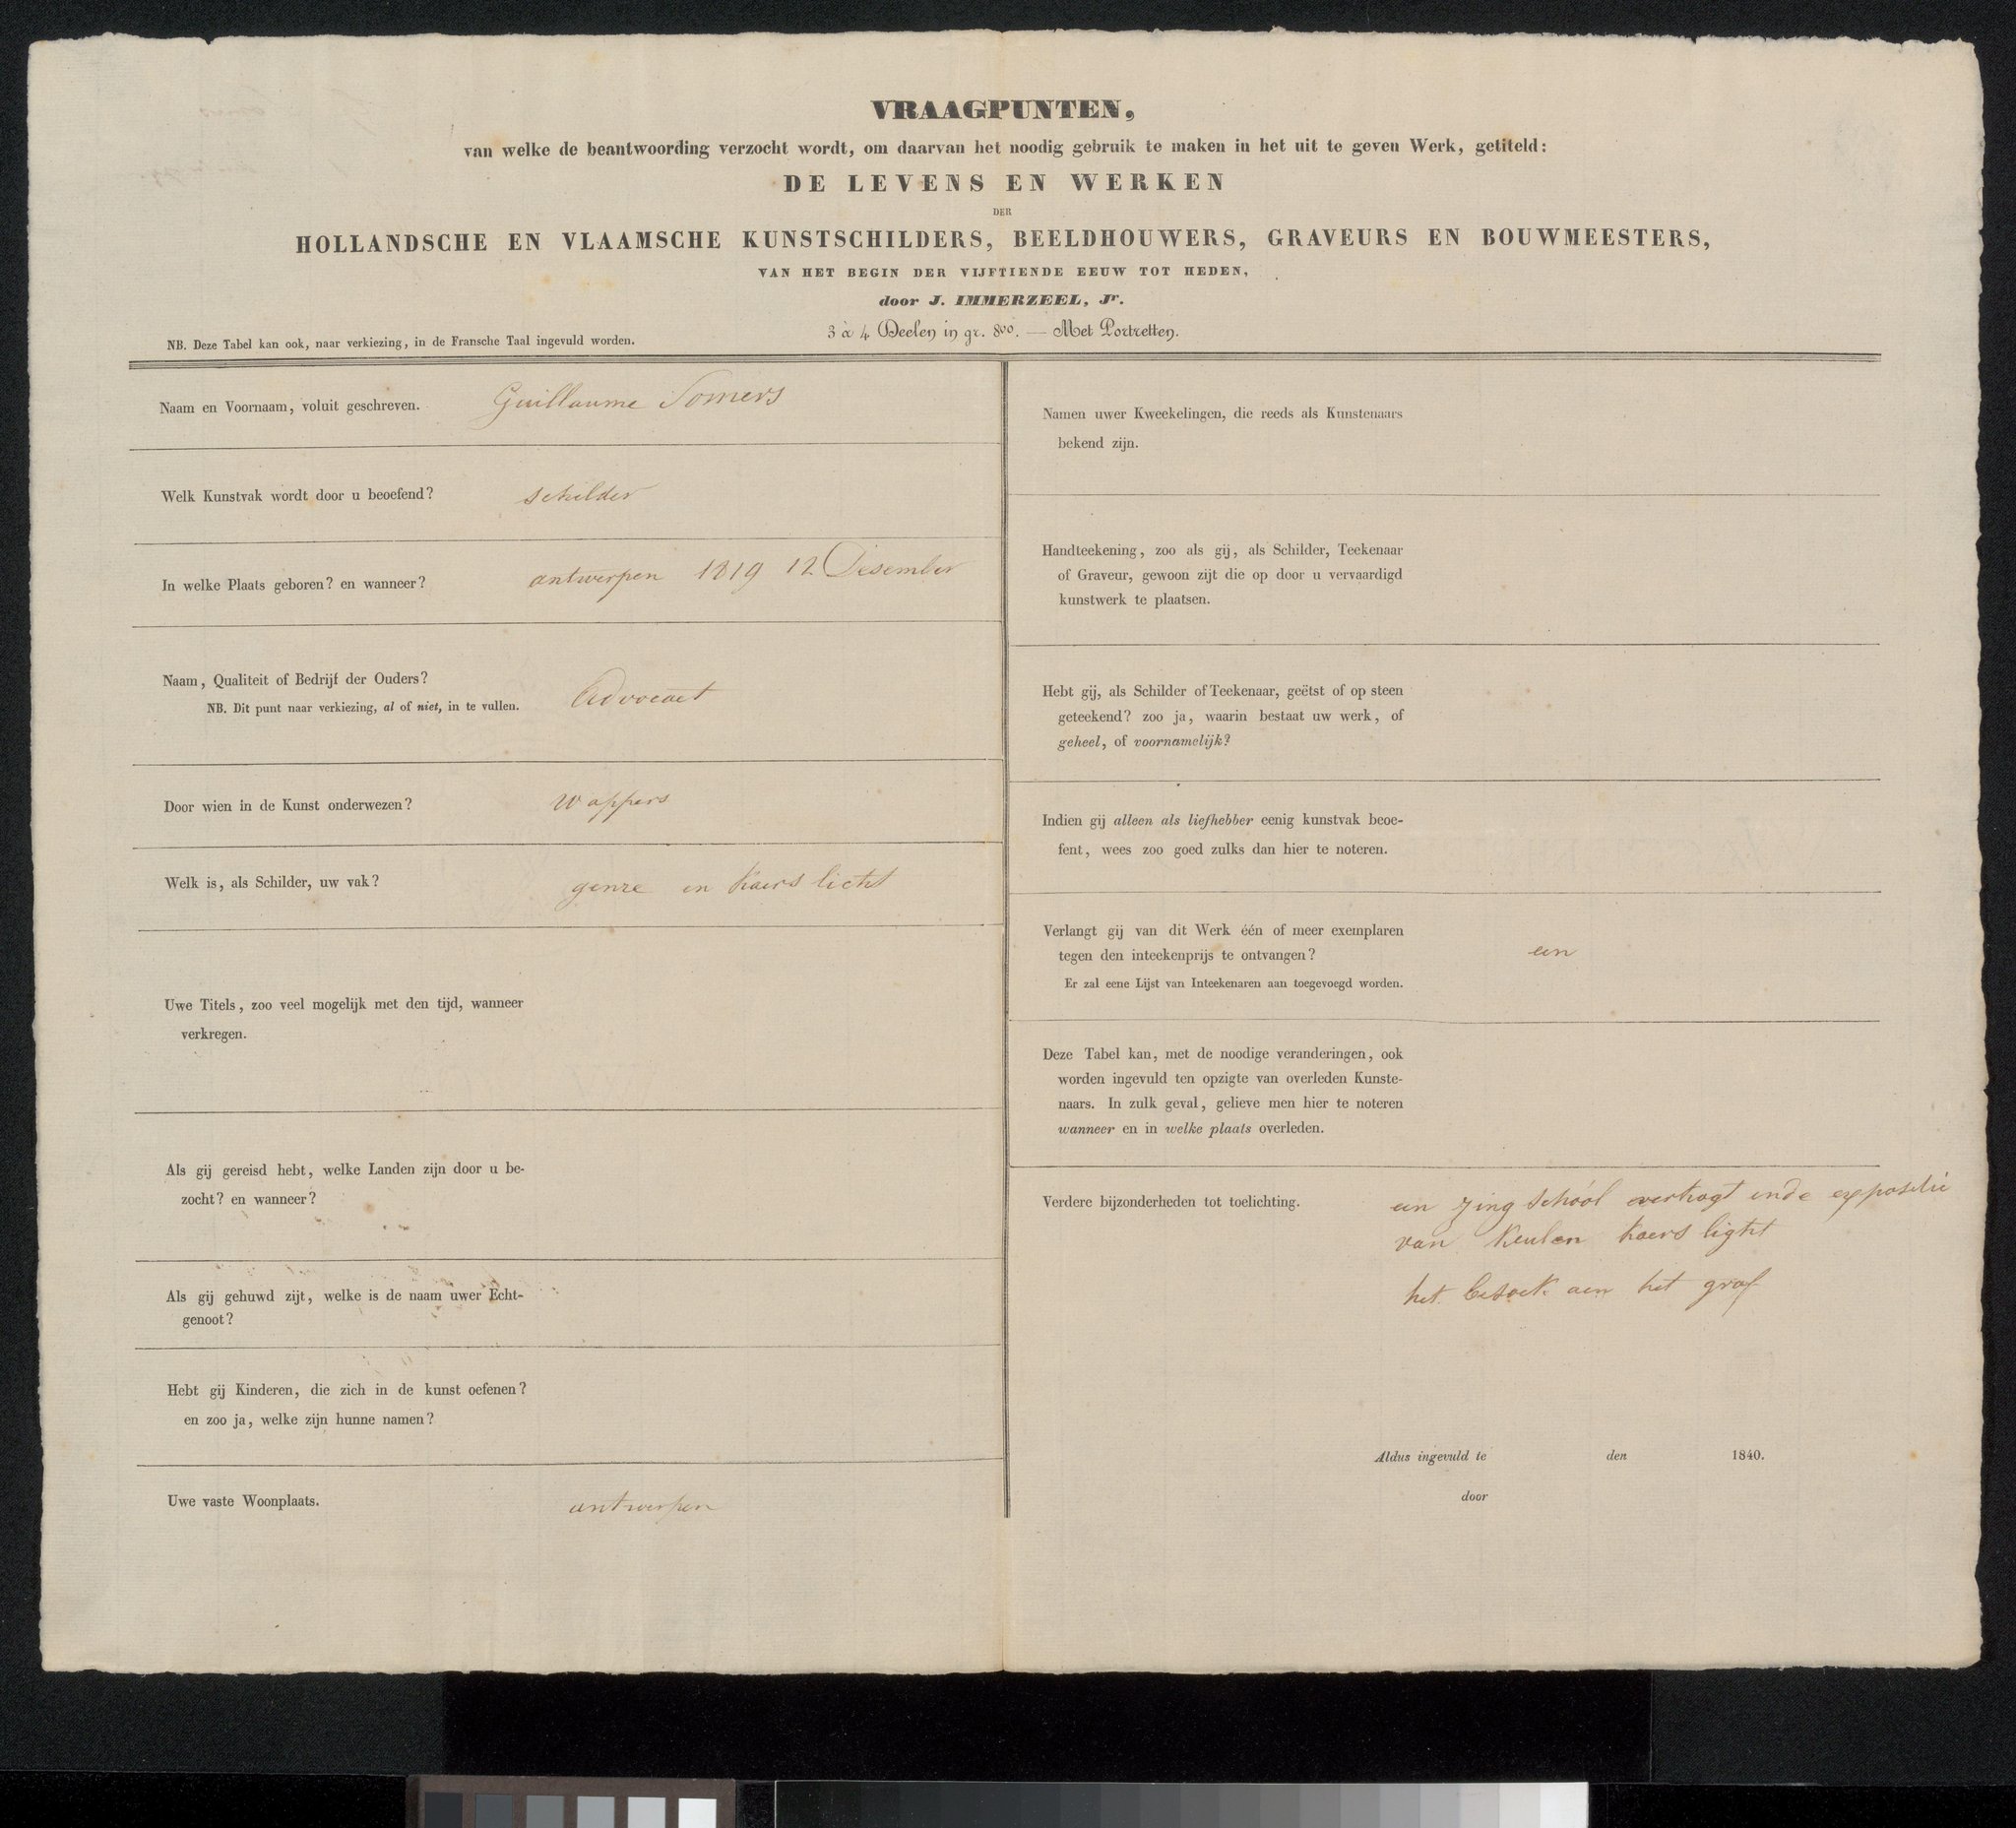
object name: manuscript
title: Enquêteformulier ingevuld door Guillaume Somers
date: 1840-1841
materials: ink, paper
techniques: pen, printing, writing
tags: antwerp, painter, guillaume somers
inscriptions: inscription: ‘Vraagpunten,/ van welke de beantwoording verzocht wordt, om daarvan het noodig gebruik te maken in het uit te geven Werk, getiteld: De levens en werken/ der Hollandsche en Vlaamsche kunstschilders, beeldhouwers,/ graveurs en bouwmeesters, van het begin der vijftiende eeuw tot heden/ door J. Immerzeel, Jr.’, watermark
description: Opgenomen in: Immerzeel, J. Jr., De levens en werken der Hollandsche en Vlaamsche kunstschilders, beeldhouwers, graveurs en bouwmeesters, van het begin der vijftiende eeuw tot heden, Amsterdam: J.C. van Kesteren, 1842-1843.